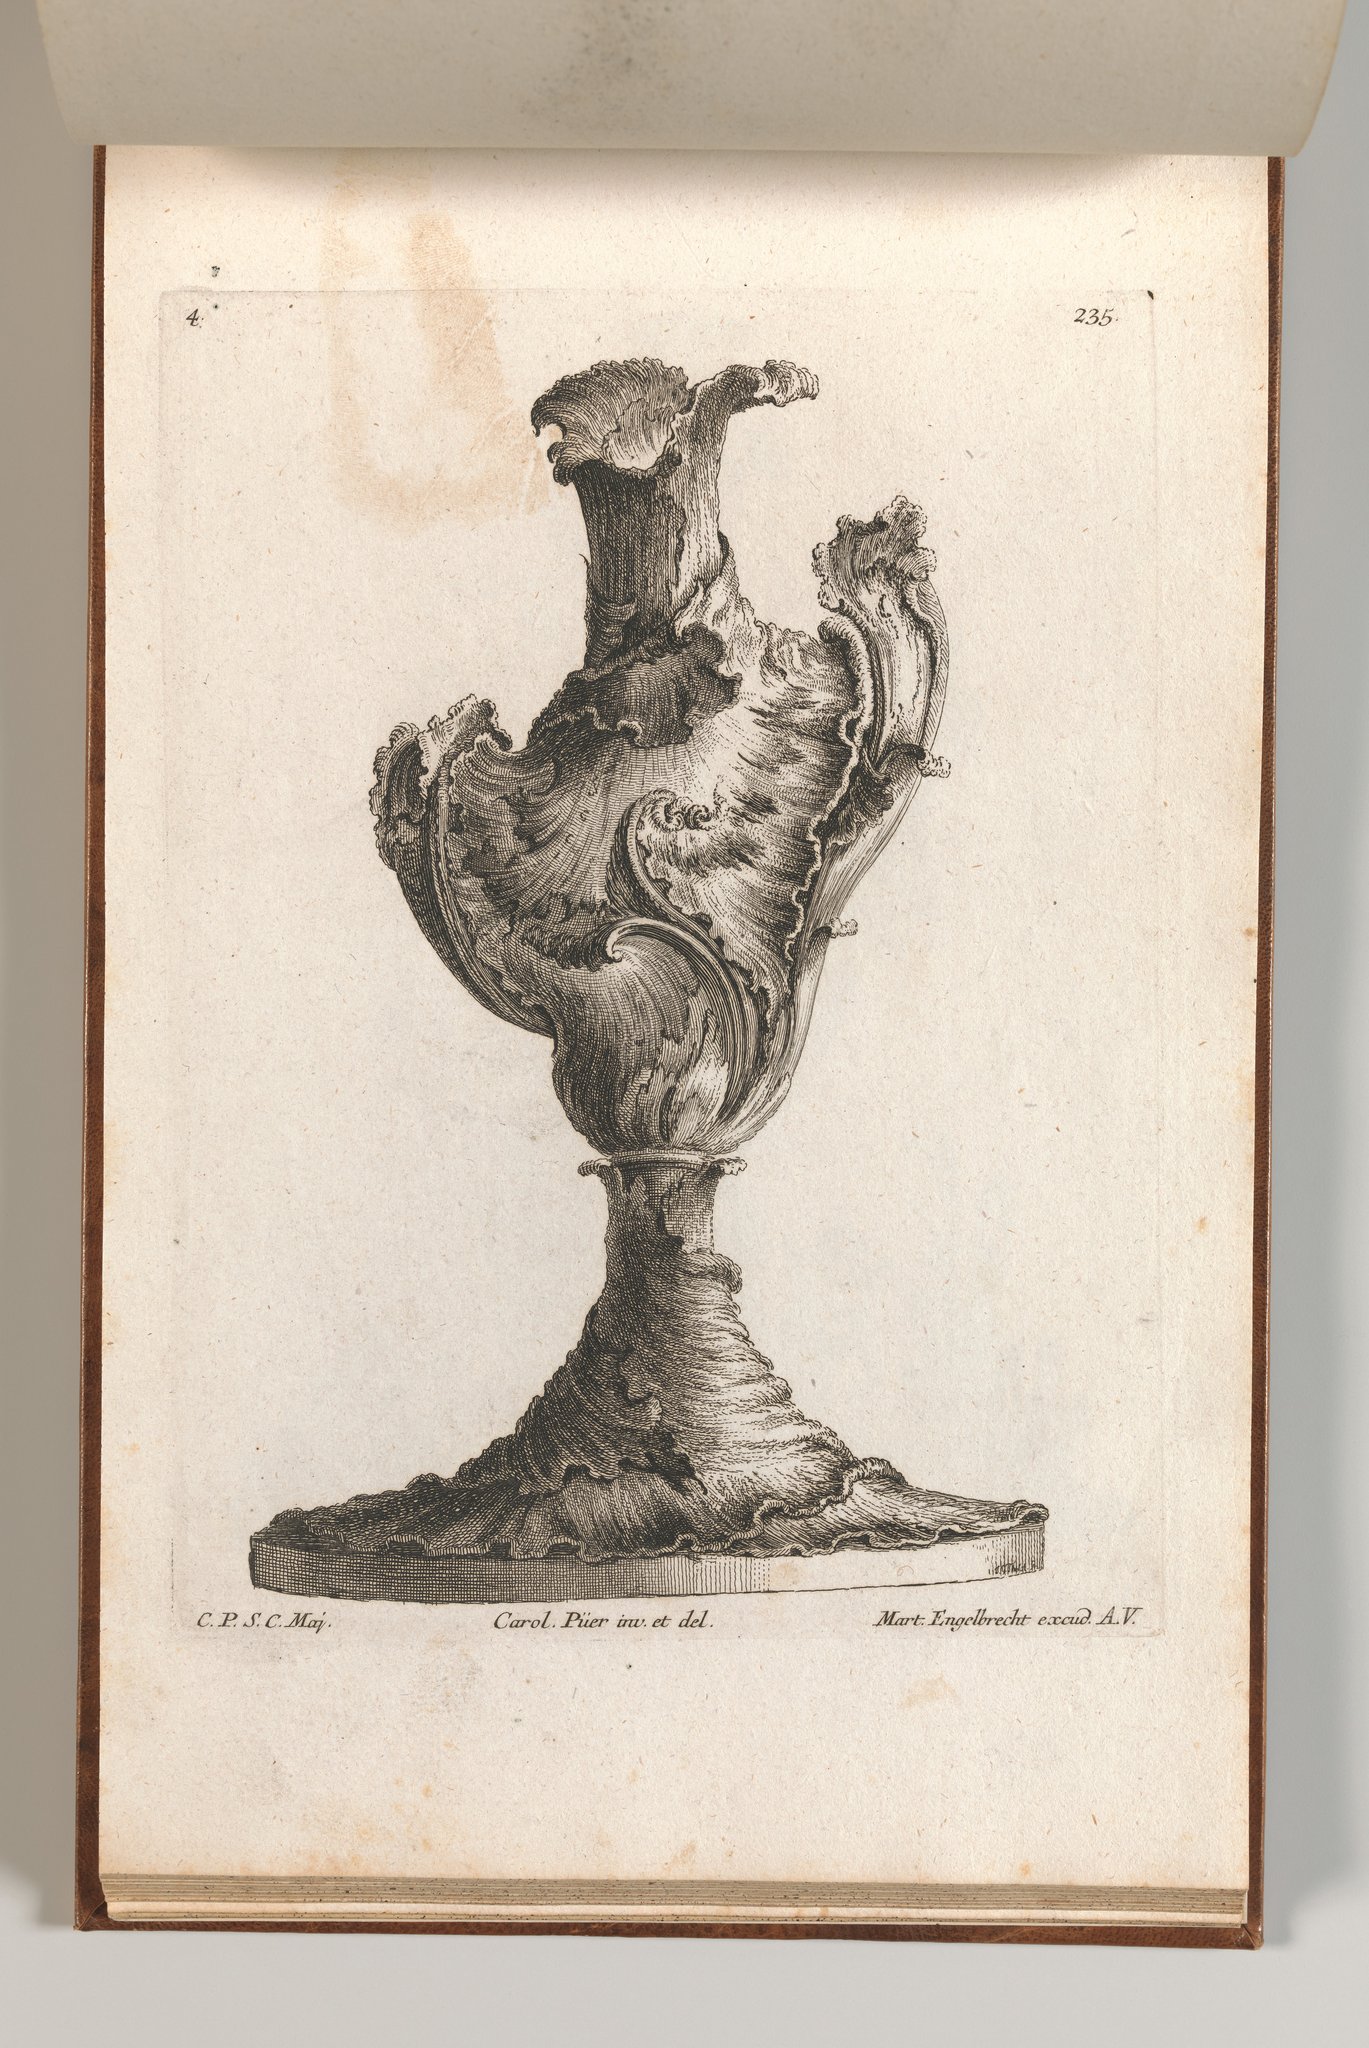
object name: album print ornament architecture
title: Design for a large Asymmetrical Vase, Plate 4 from: 'Neu inventierte Vasi auf die neueste manier'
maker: jacob gottlieb thelot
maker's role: engraver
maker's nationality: central european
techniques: etching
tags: vases